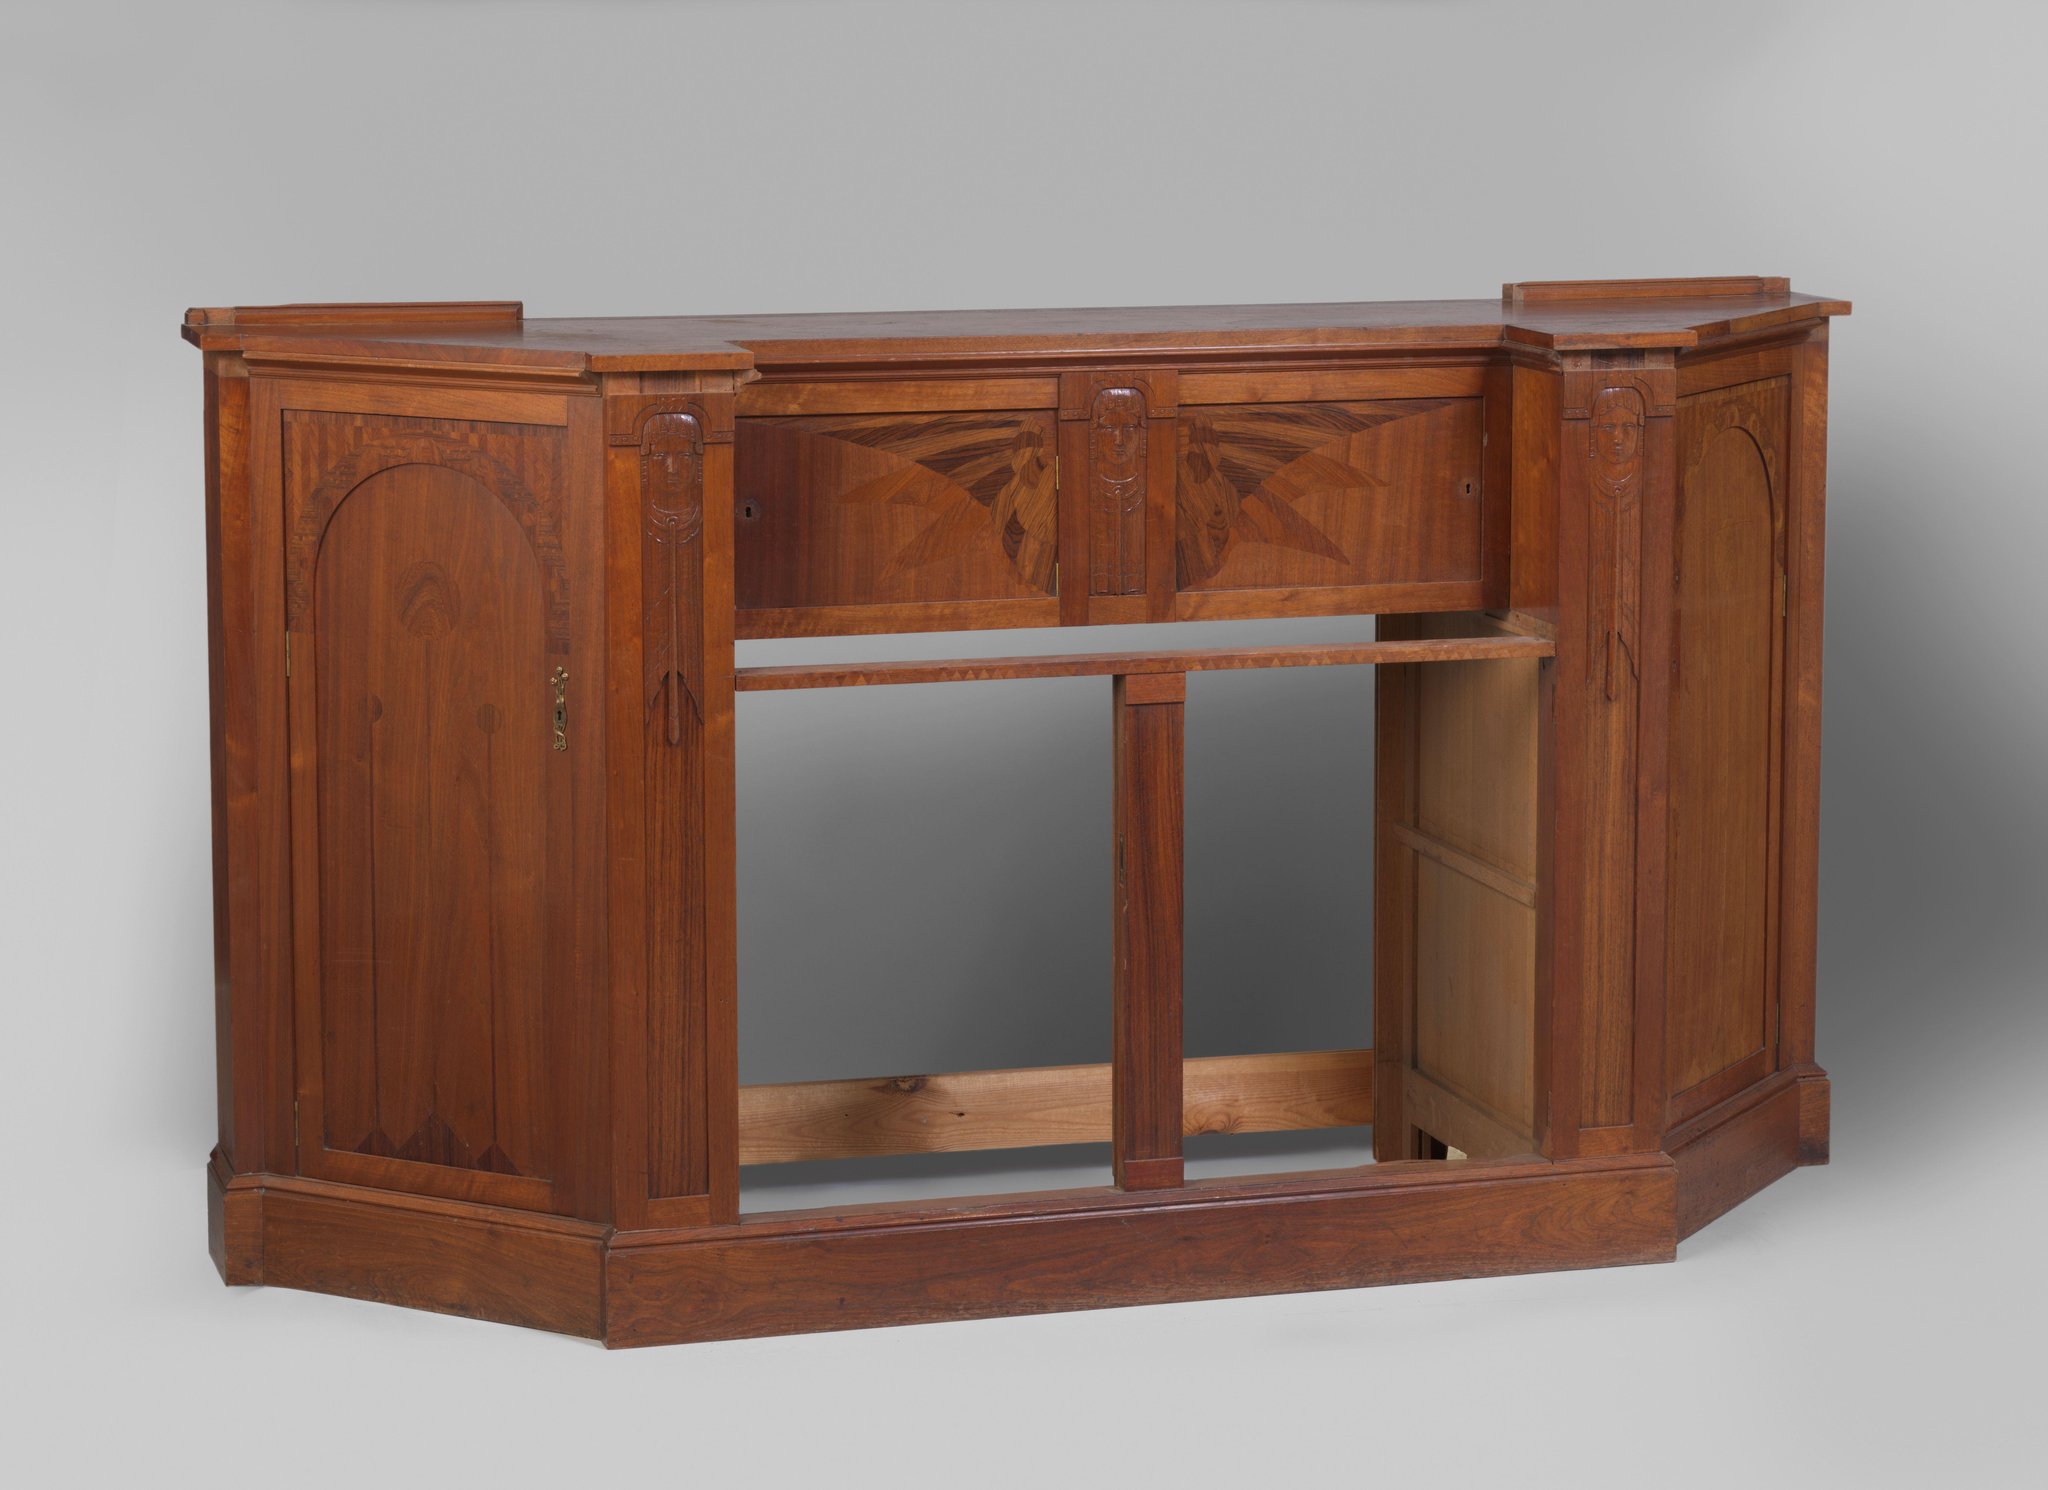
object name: dressoir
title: Dressoir, onderdeel van een betimmering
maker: napoleon le grand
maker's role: furniture worker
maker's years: 1857-1932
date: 1900-1905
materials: brass, wood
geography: amsterdam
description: Dressoir, onderdeel van een betimmering, uitgevoerd in notenhout, eiken, palissander en messing.